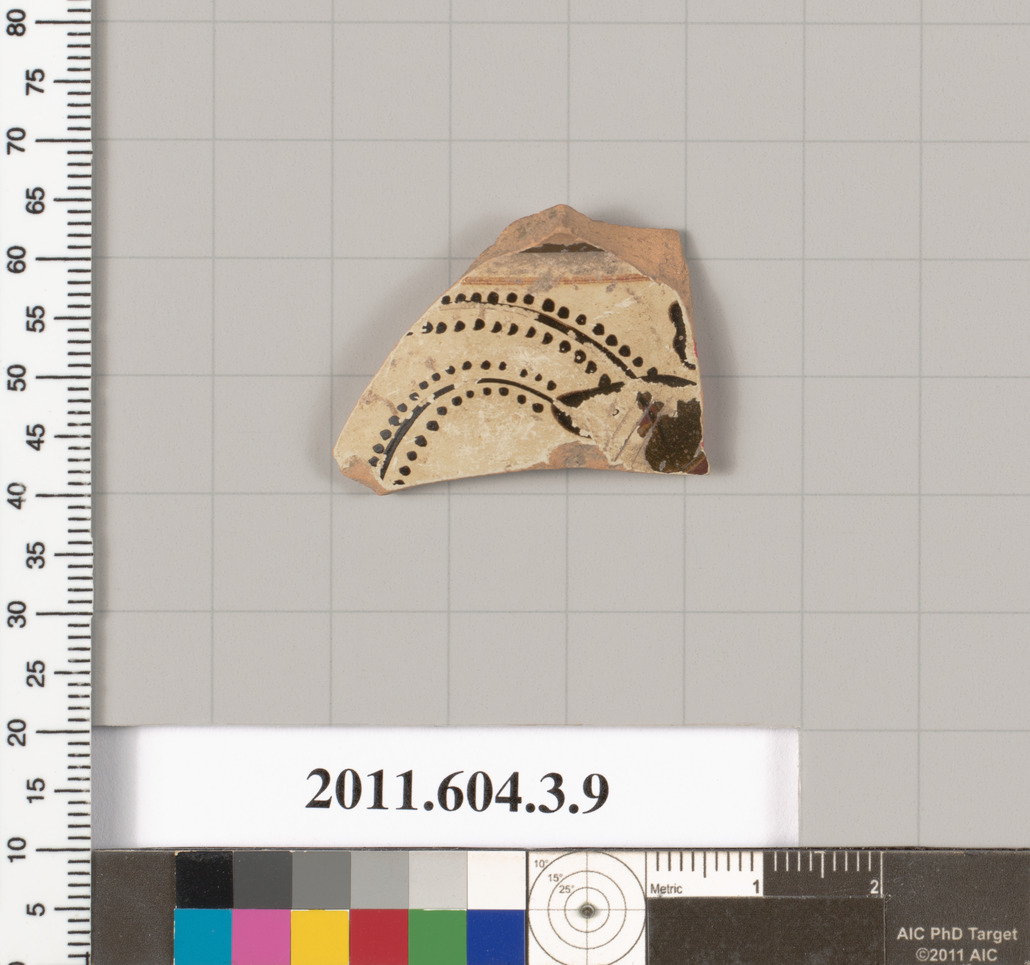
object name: mastoid fragment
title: Terracotta fragment of a mastoid?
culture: greek, attic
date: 500-476 BCE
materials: terracotta